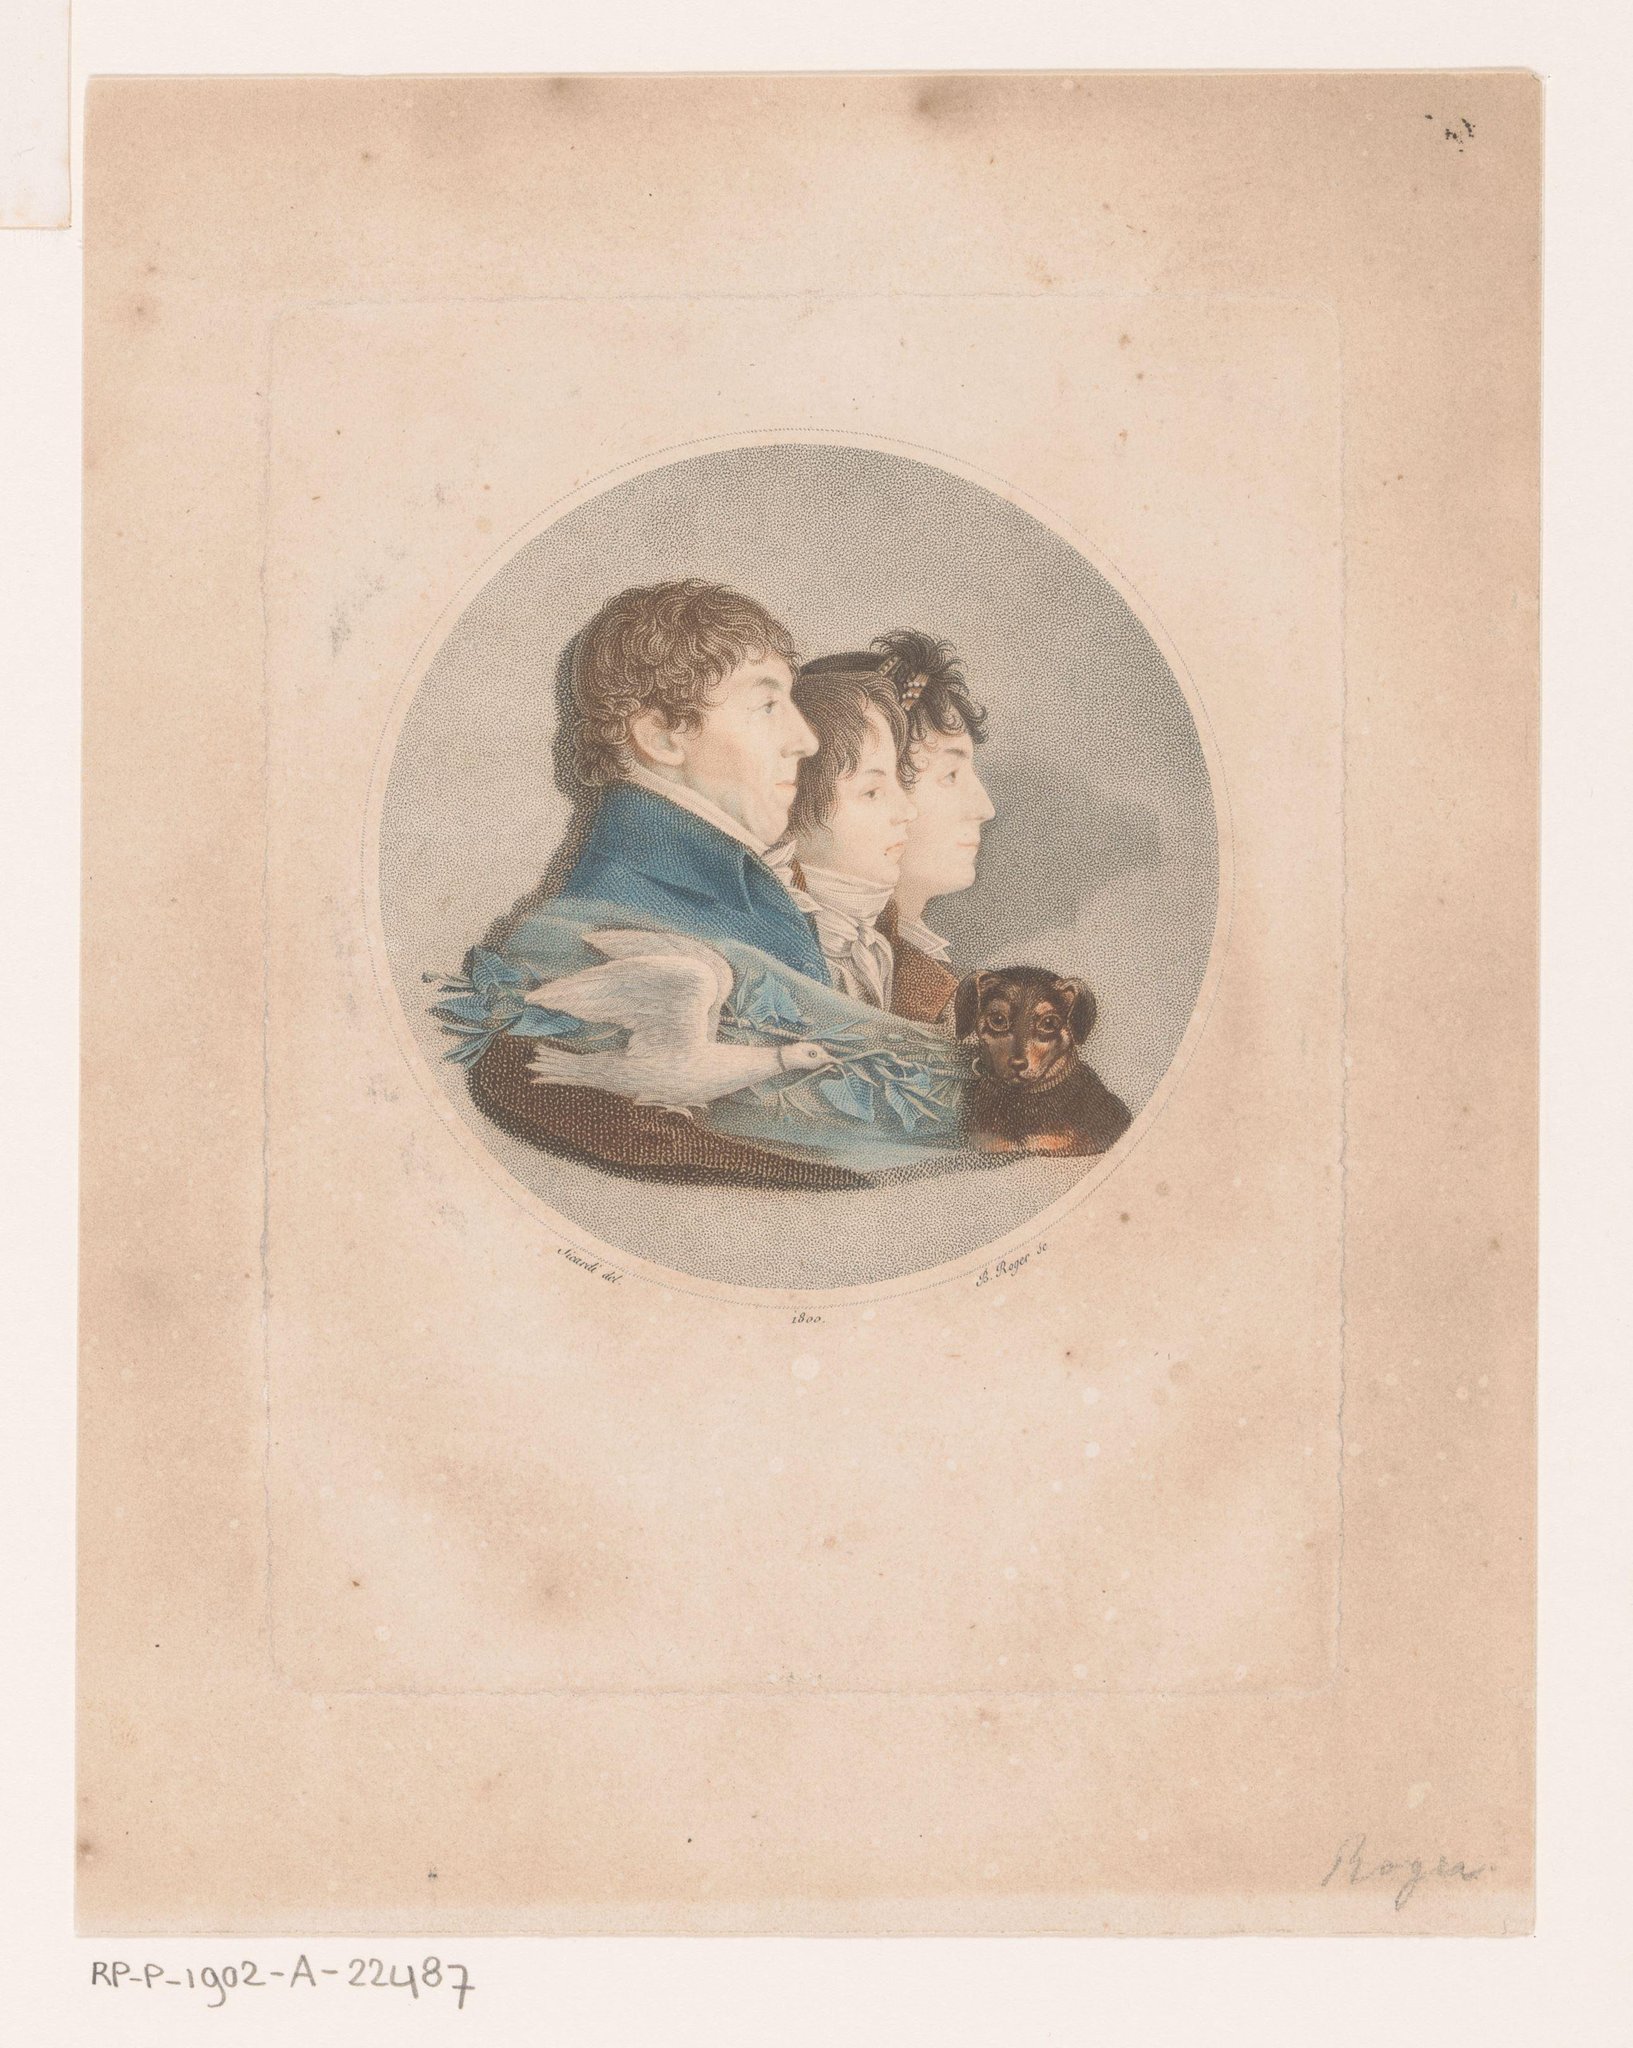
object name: print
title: Portret van Jacques Marie Louis van Rechteren met zijn vrouw en zoon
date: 1800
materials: paper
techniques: etching, hand coloring, lithography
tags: earl, parents with their children, historical persons, dog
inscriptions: collector's mark: Lugt 2228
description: Latere staat van RP-P-1902-A-22486 met verandering van de hond rechts.